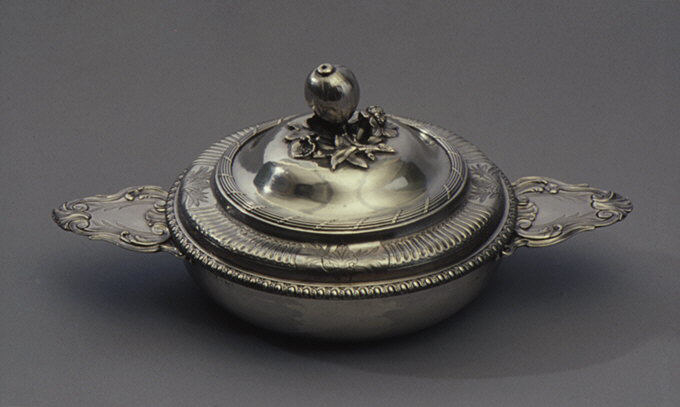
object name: bowl with cover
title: Bowl with cover (Écuelle)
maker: simon bourguet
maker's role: maker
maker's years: 1705-1773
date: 1752-1762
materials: silver